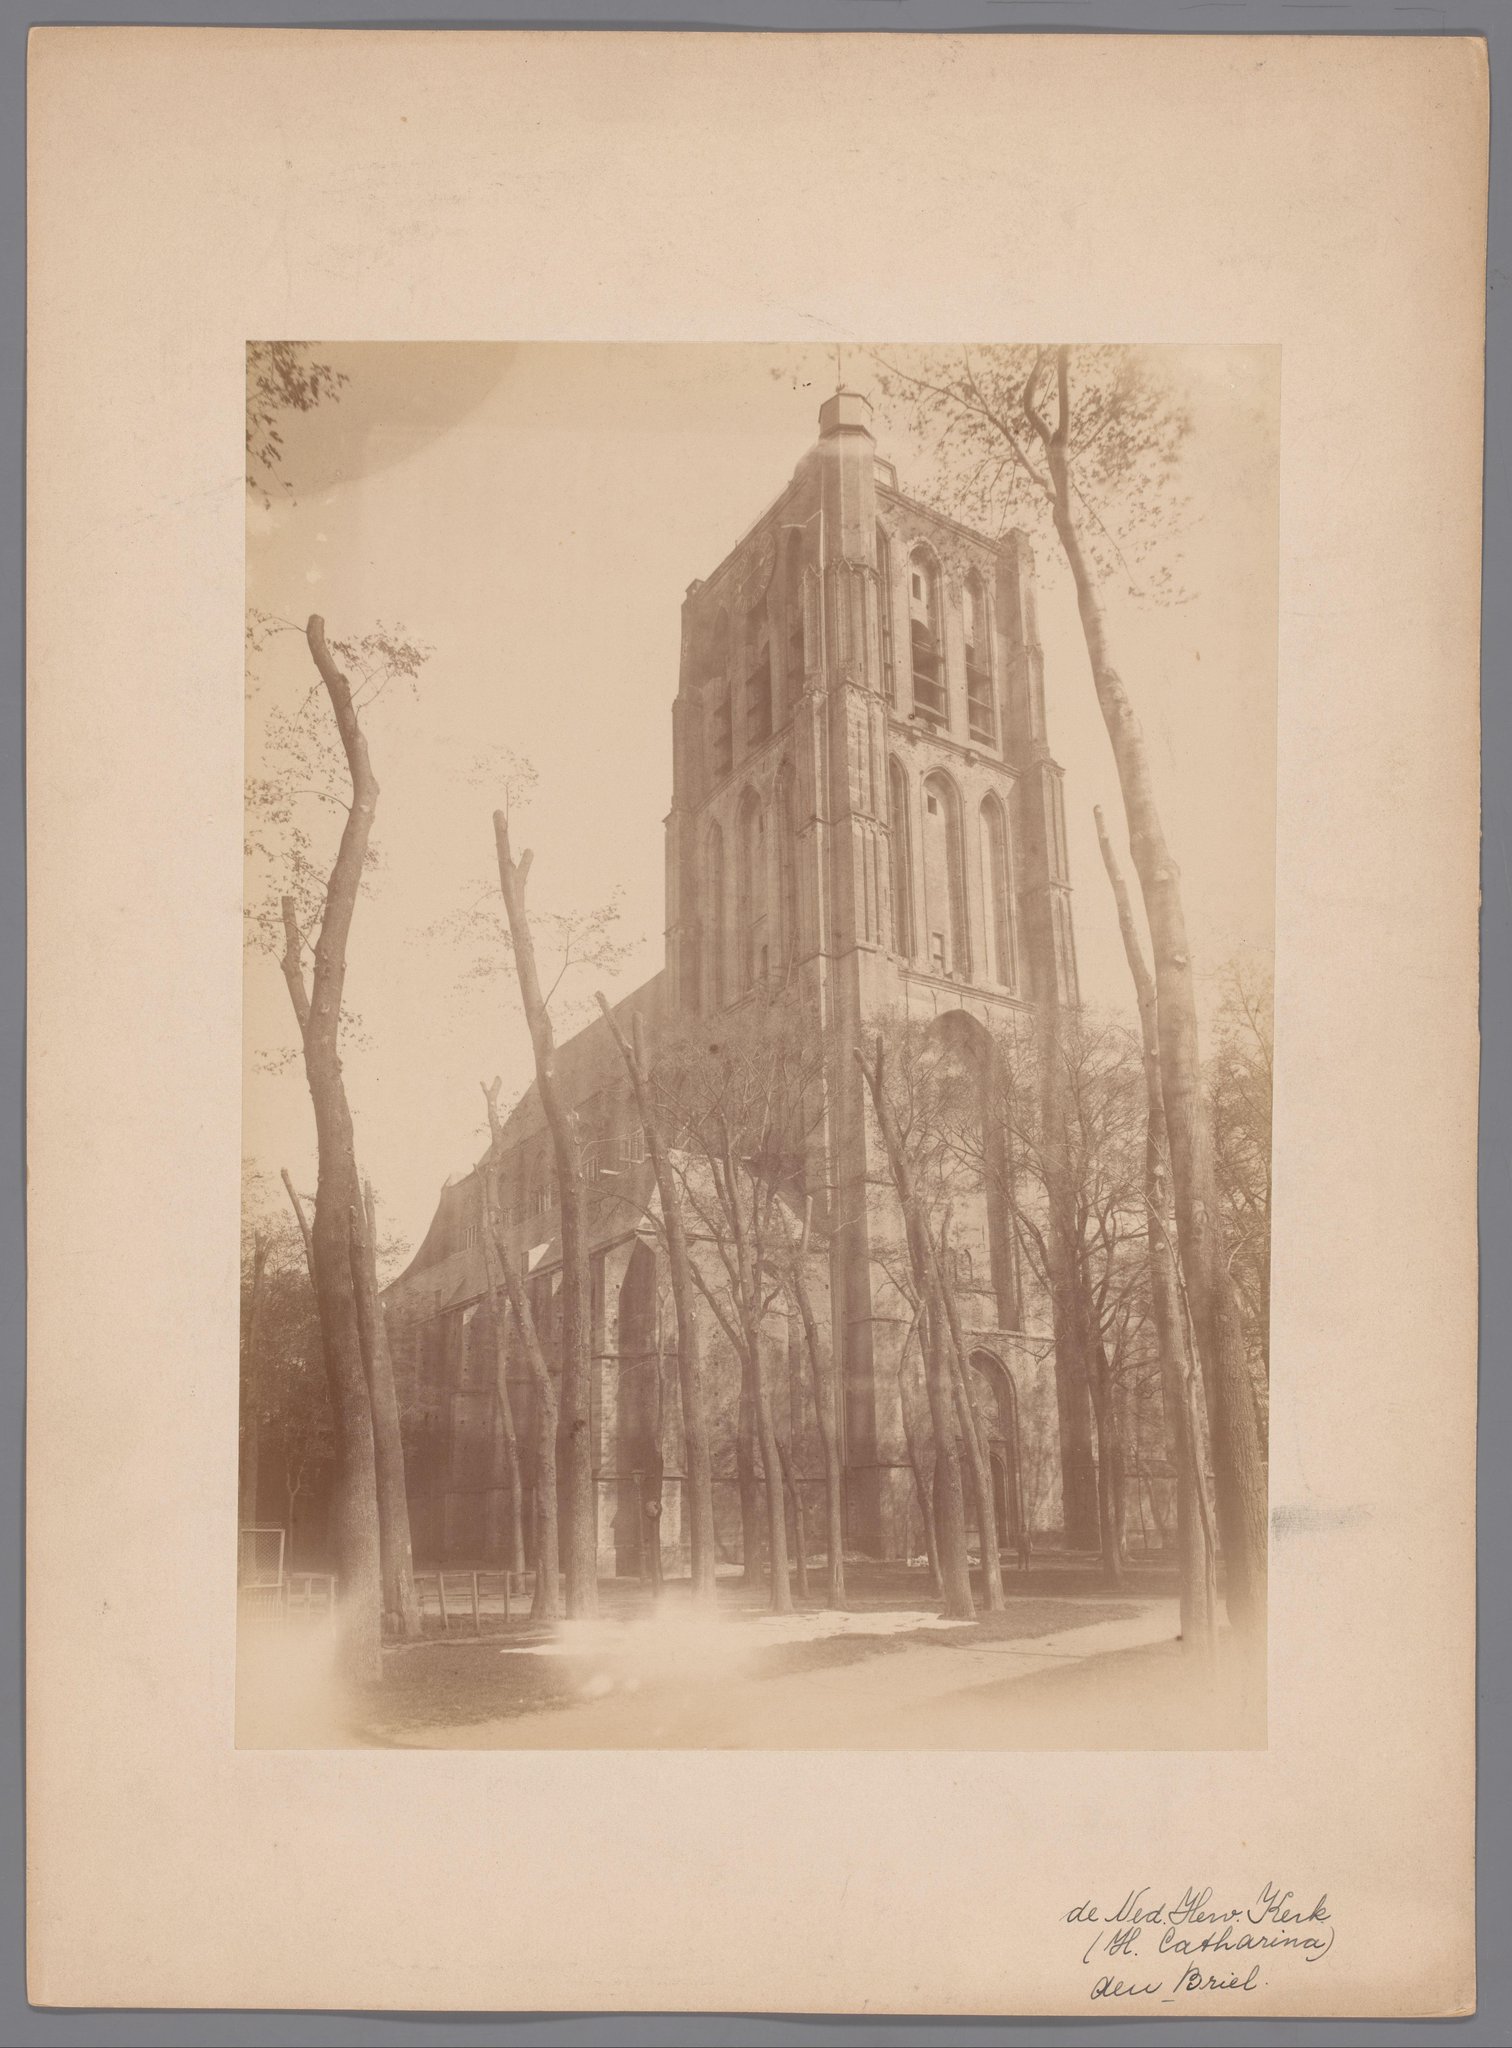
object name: photograph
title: Grote of Sint-Catharijnekerk te Bielle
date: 1885-1905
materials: cardboard, photographic support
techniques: albumen print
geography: brielle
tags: church (exterior), tower (of house or building)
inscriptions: annotation: ‘Brielle/ N.H. Kerk’, annotation: ‘De Ned. Herv. Kerk (H. Catharina)/ den Briel’